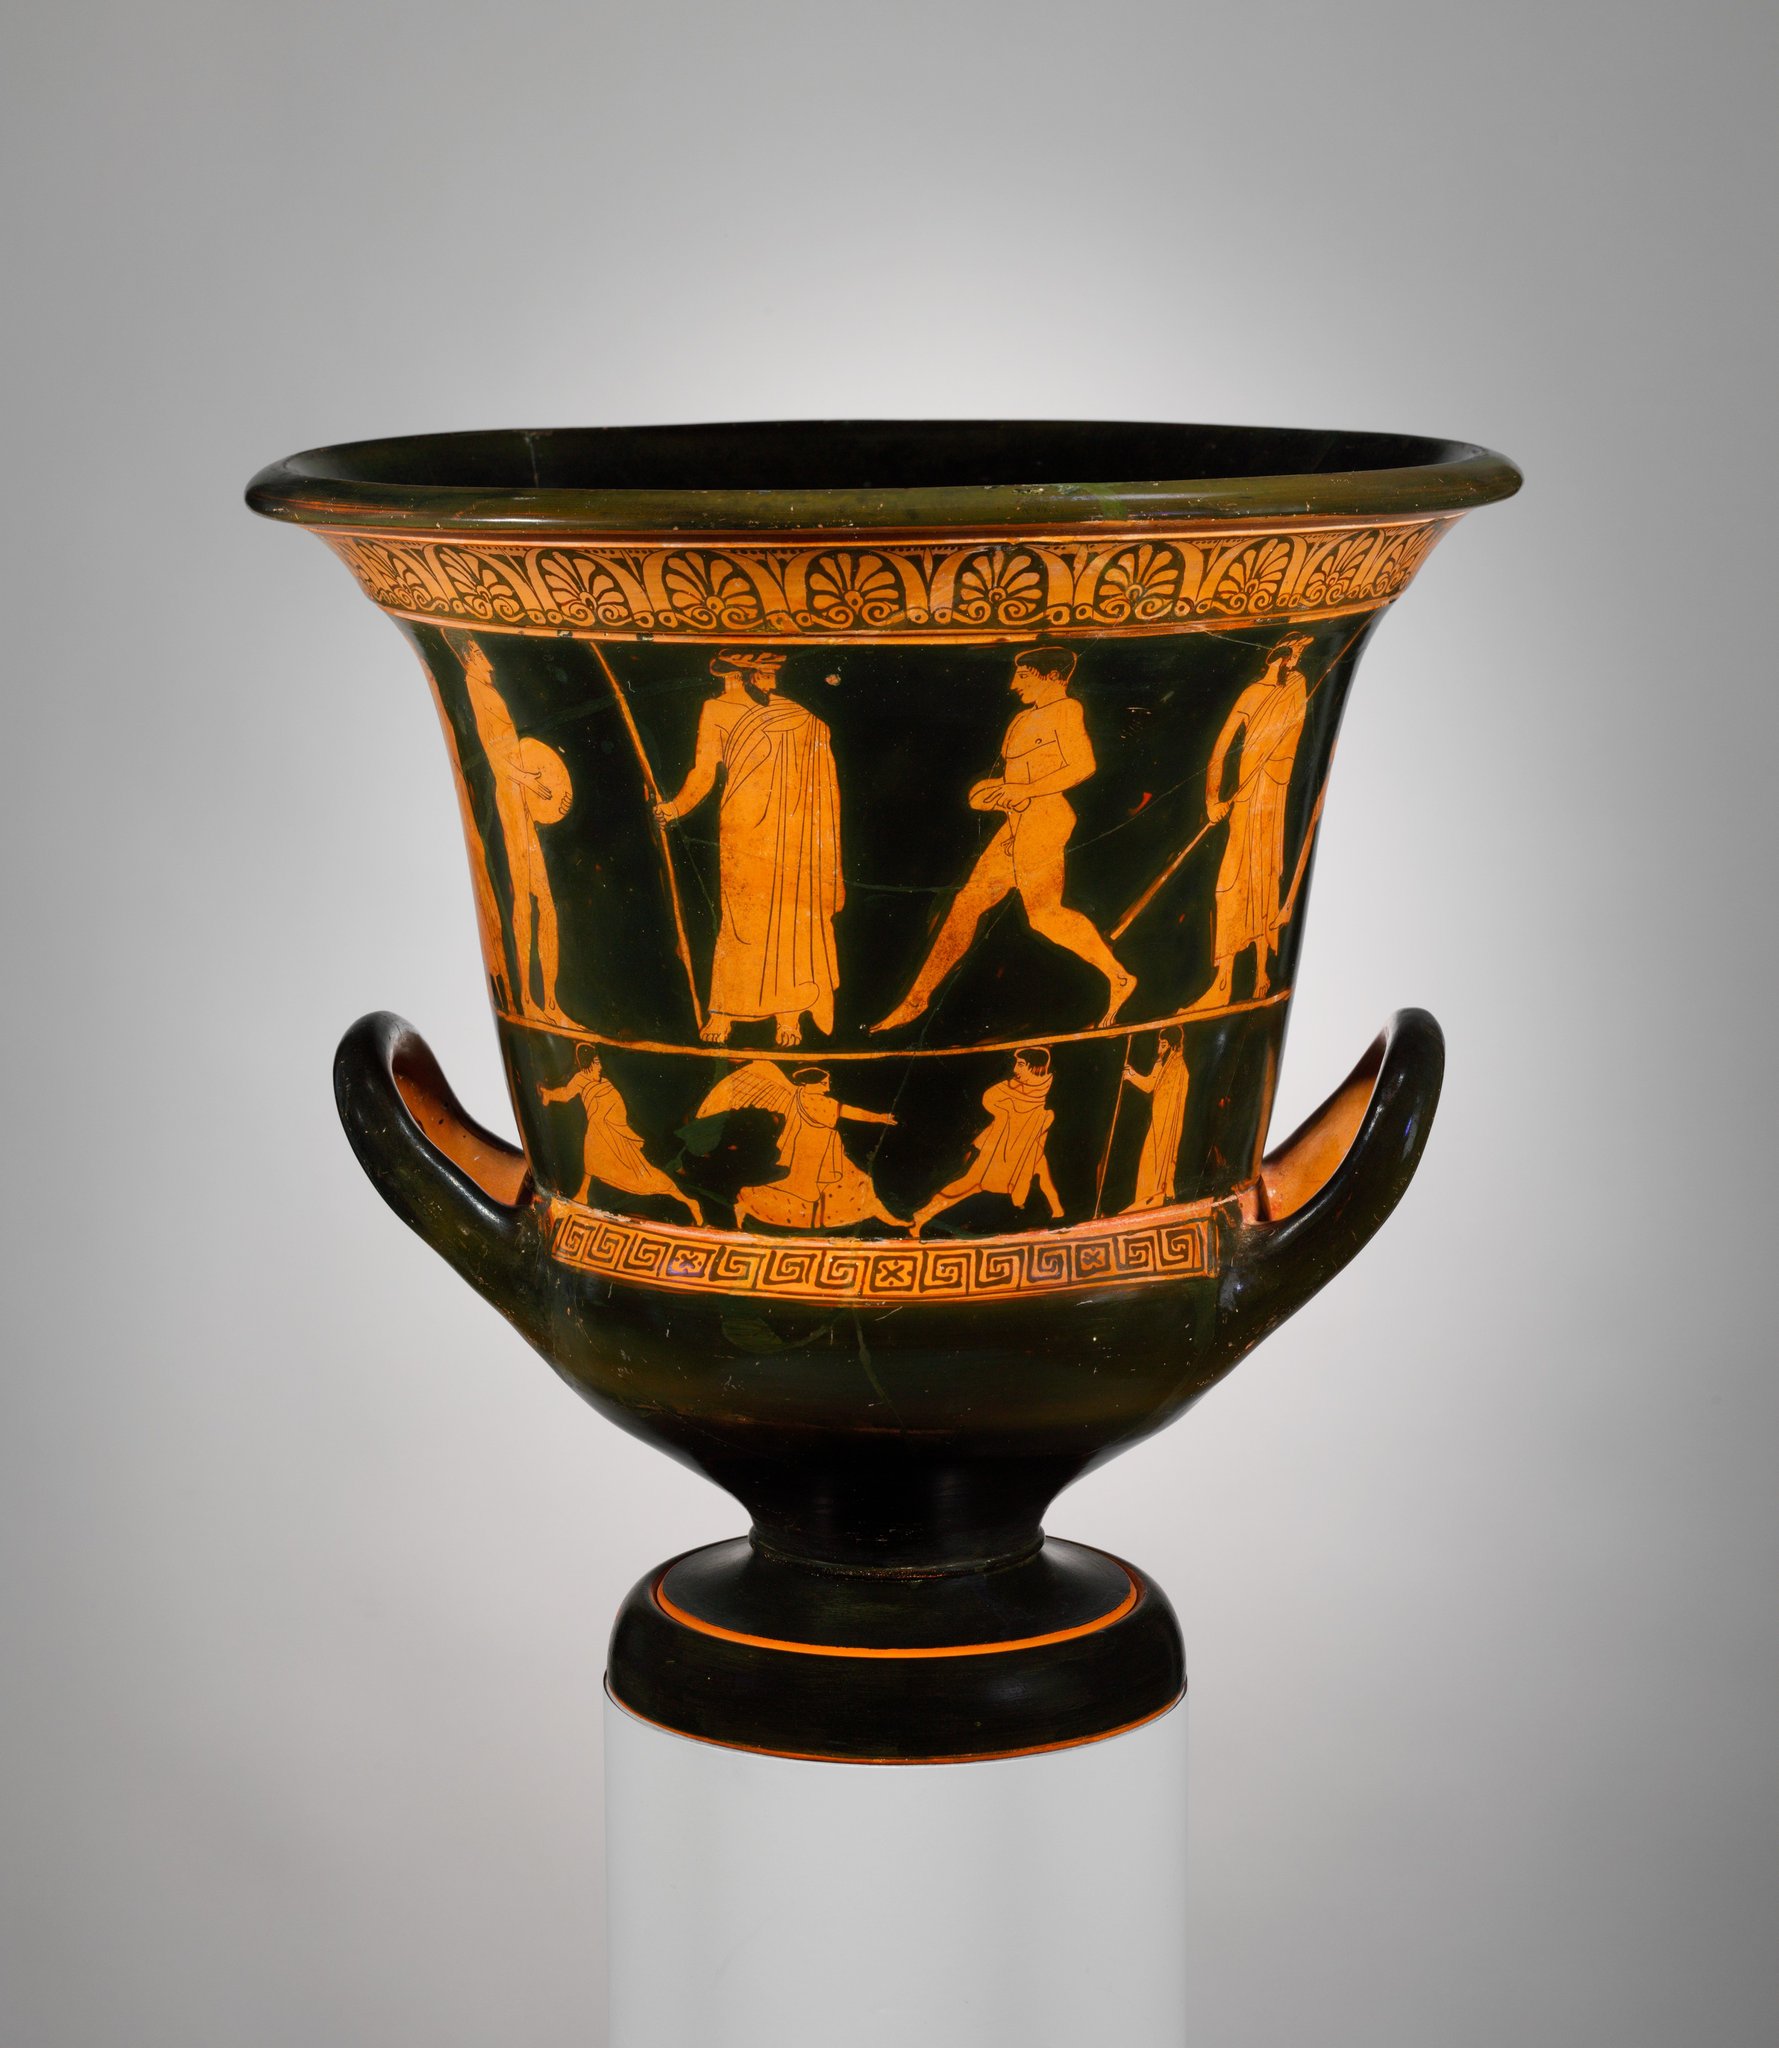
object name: calyx krater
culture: greek, attic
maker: painter of the louvre centauromachy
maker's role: artist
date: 440 BCE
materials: terracotta